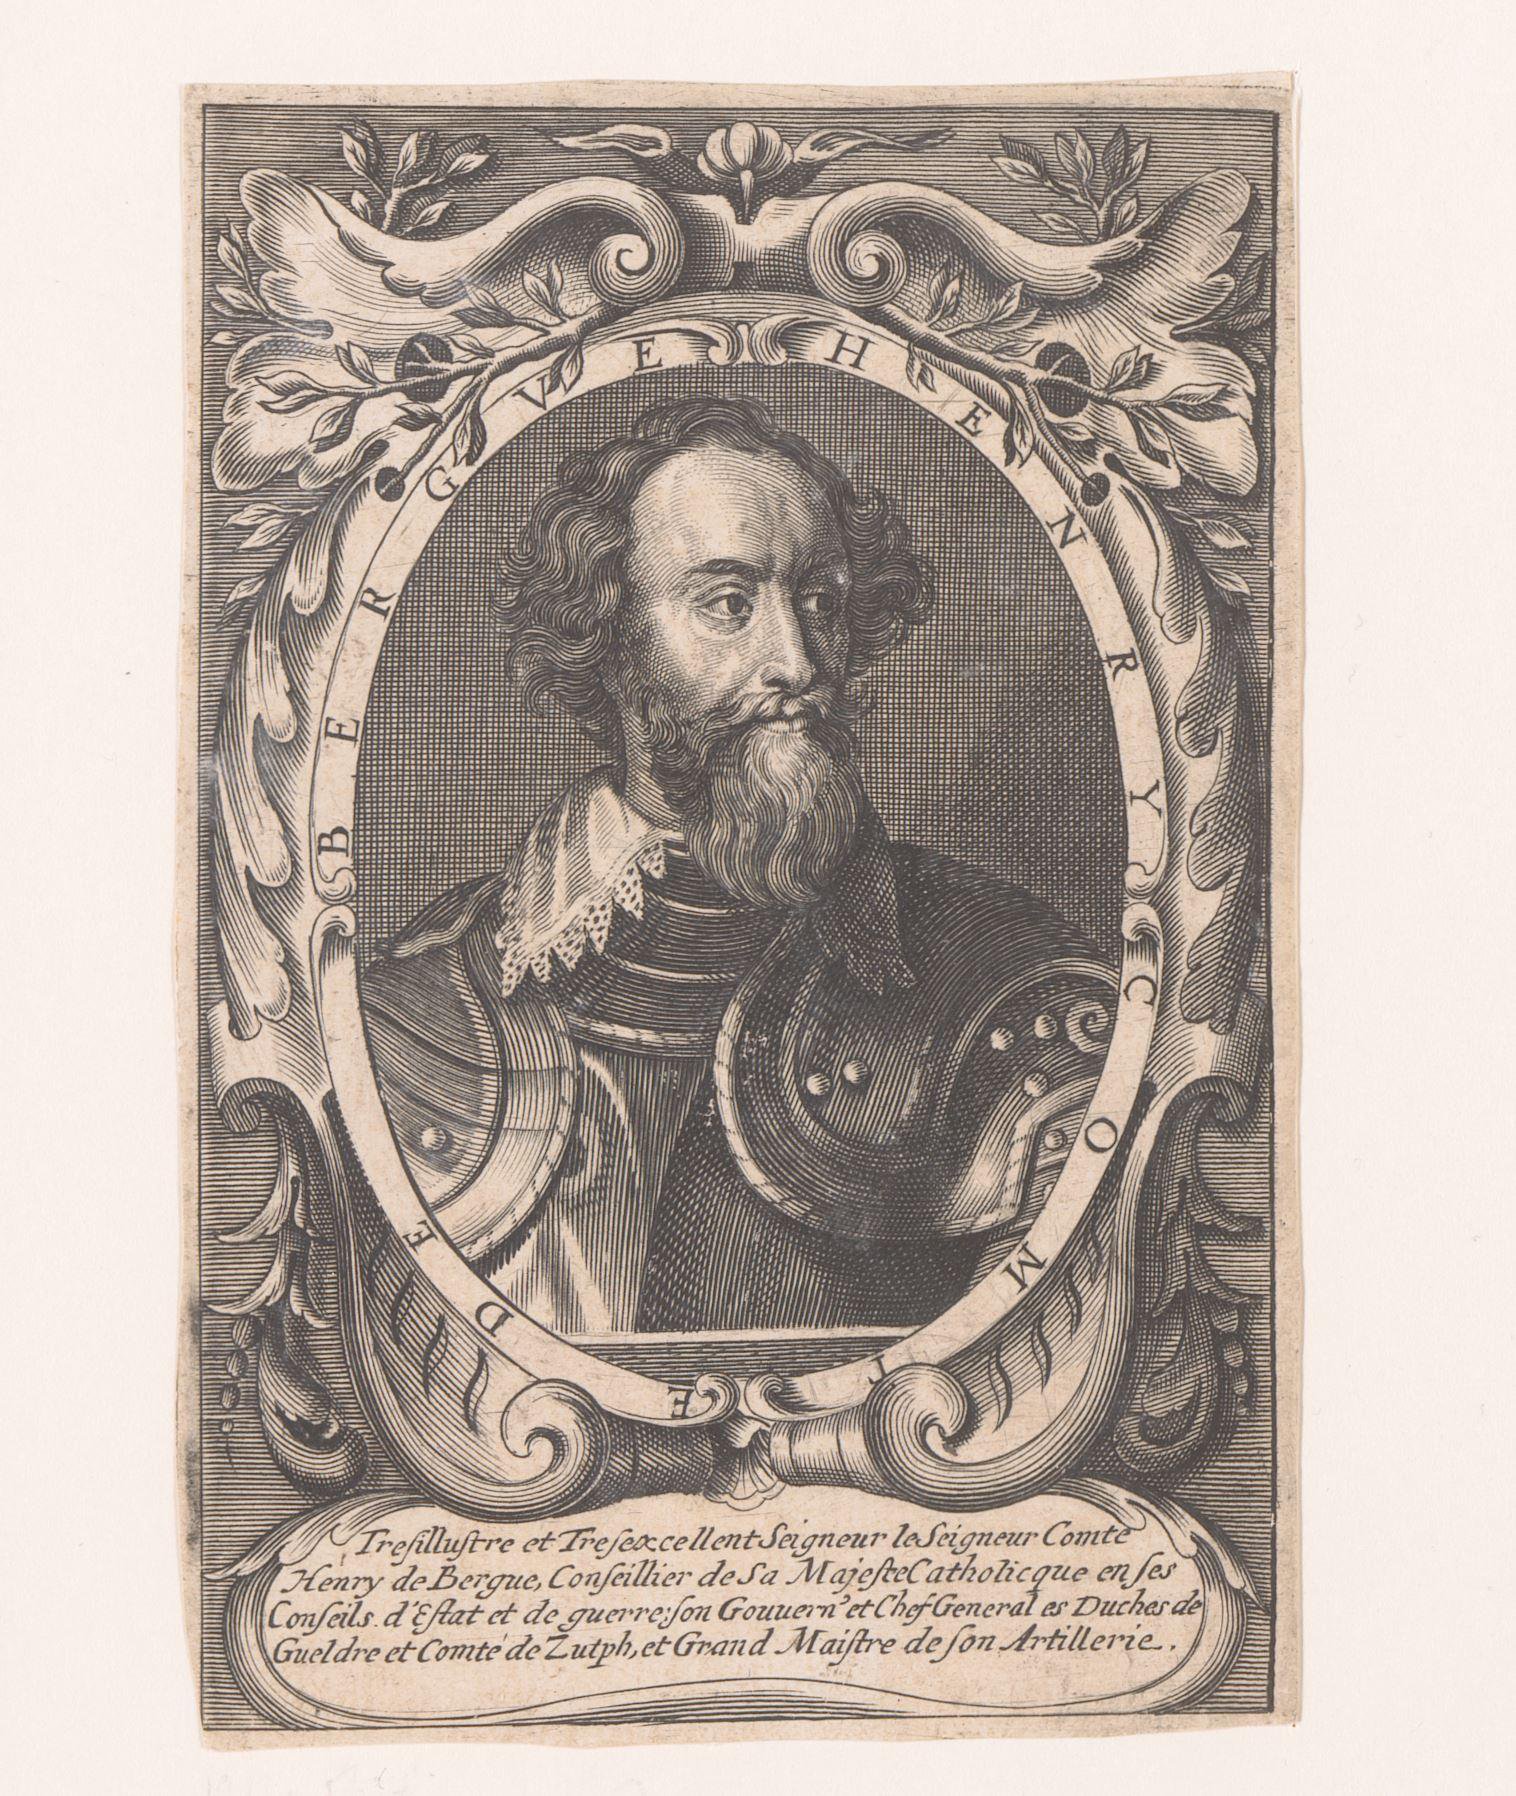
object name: print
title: Portret van Hendrik van den Bergh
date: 1610-1668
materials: paper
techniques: engraving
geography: paris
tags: earl, historical persons, nobility and patriciate; chivalry, knighthood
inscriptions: collector's mark: Lugt 2228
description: Deze anonieme prent is vermoedelijk slechts gebaseerd op een prent uitgegeven door Balthasar Moncornet. Zie RP-P-OB-71.402.